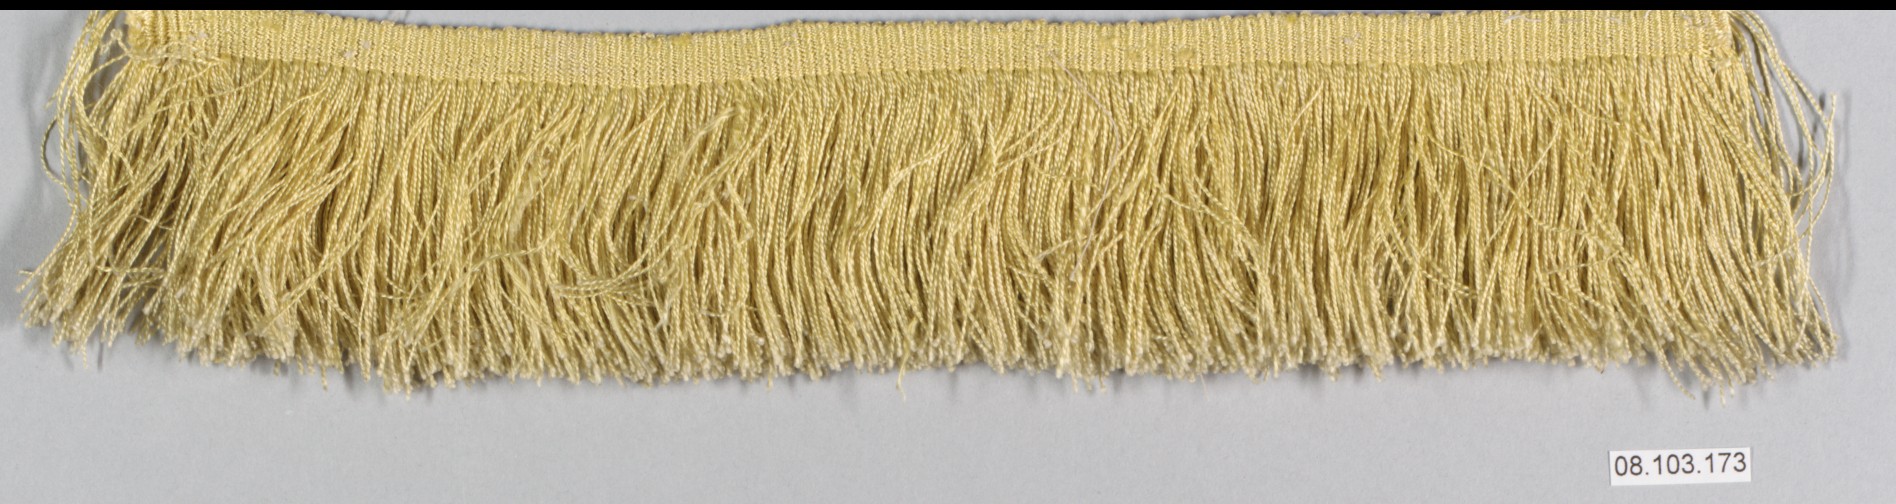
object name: fringe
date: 1801-1900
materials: silk